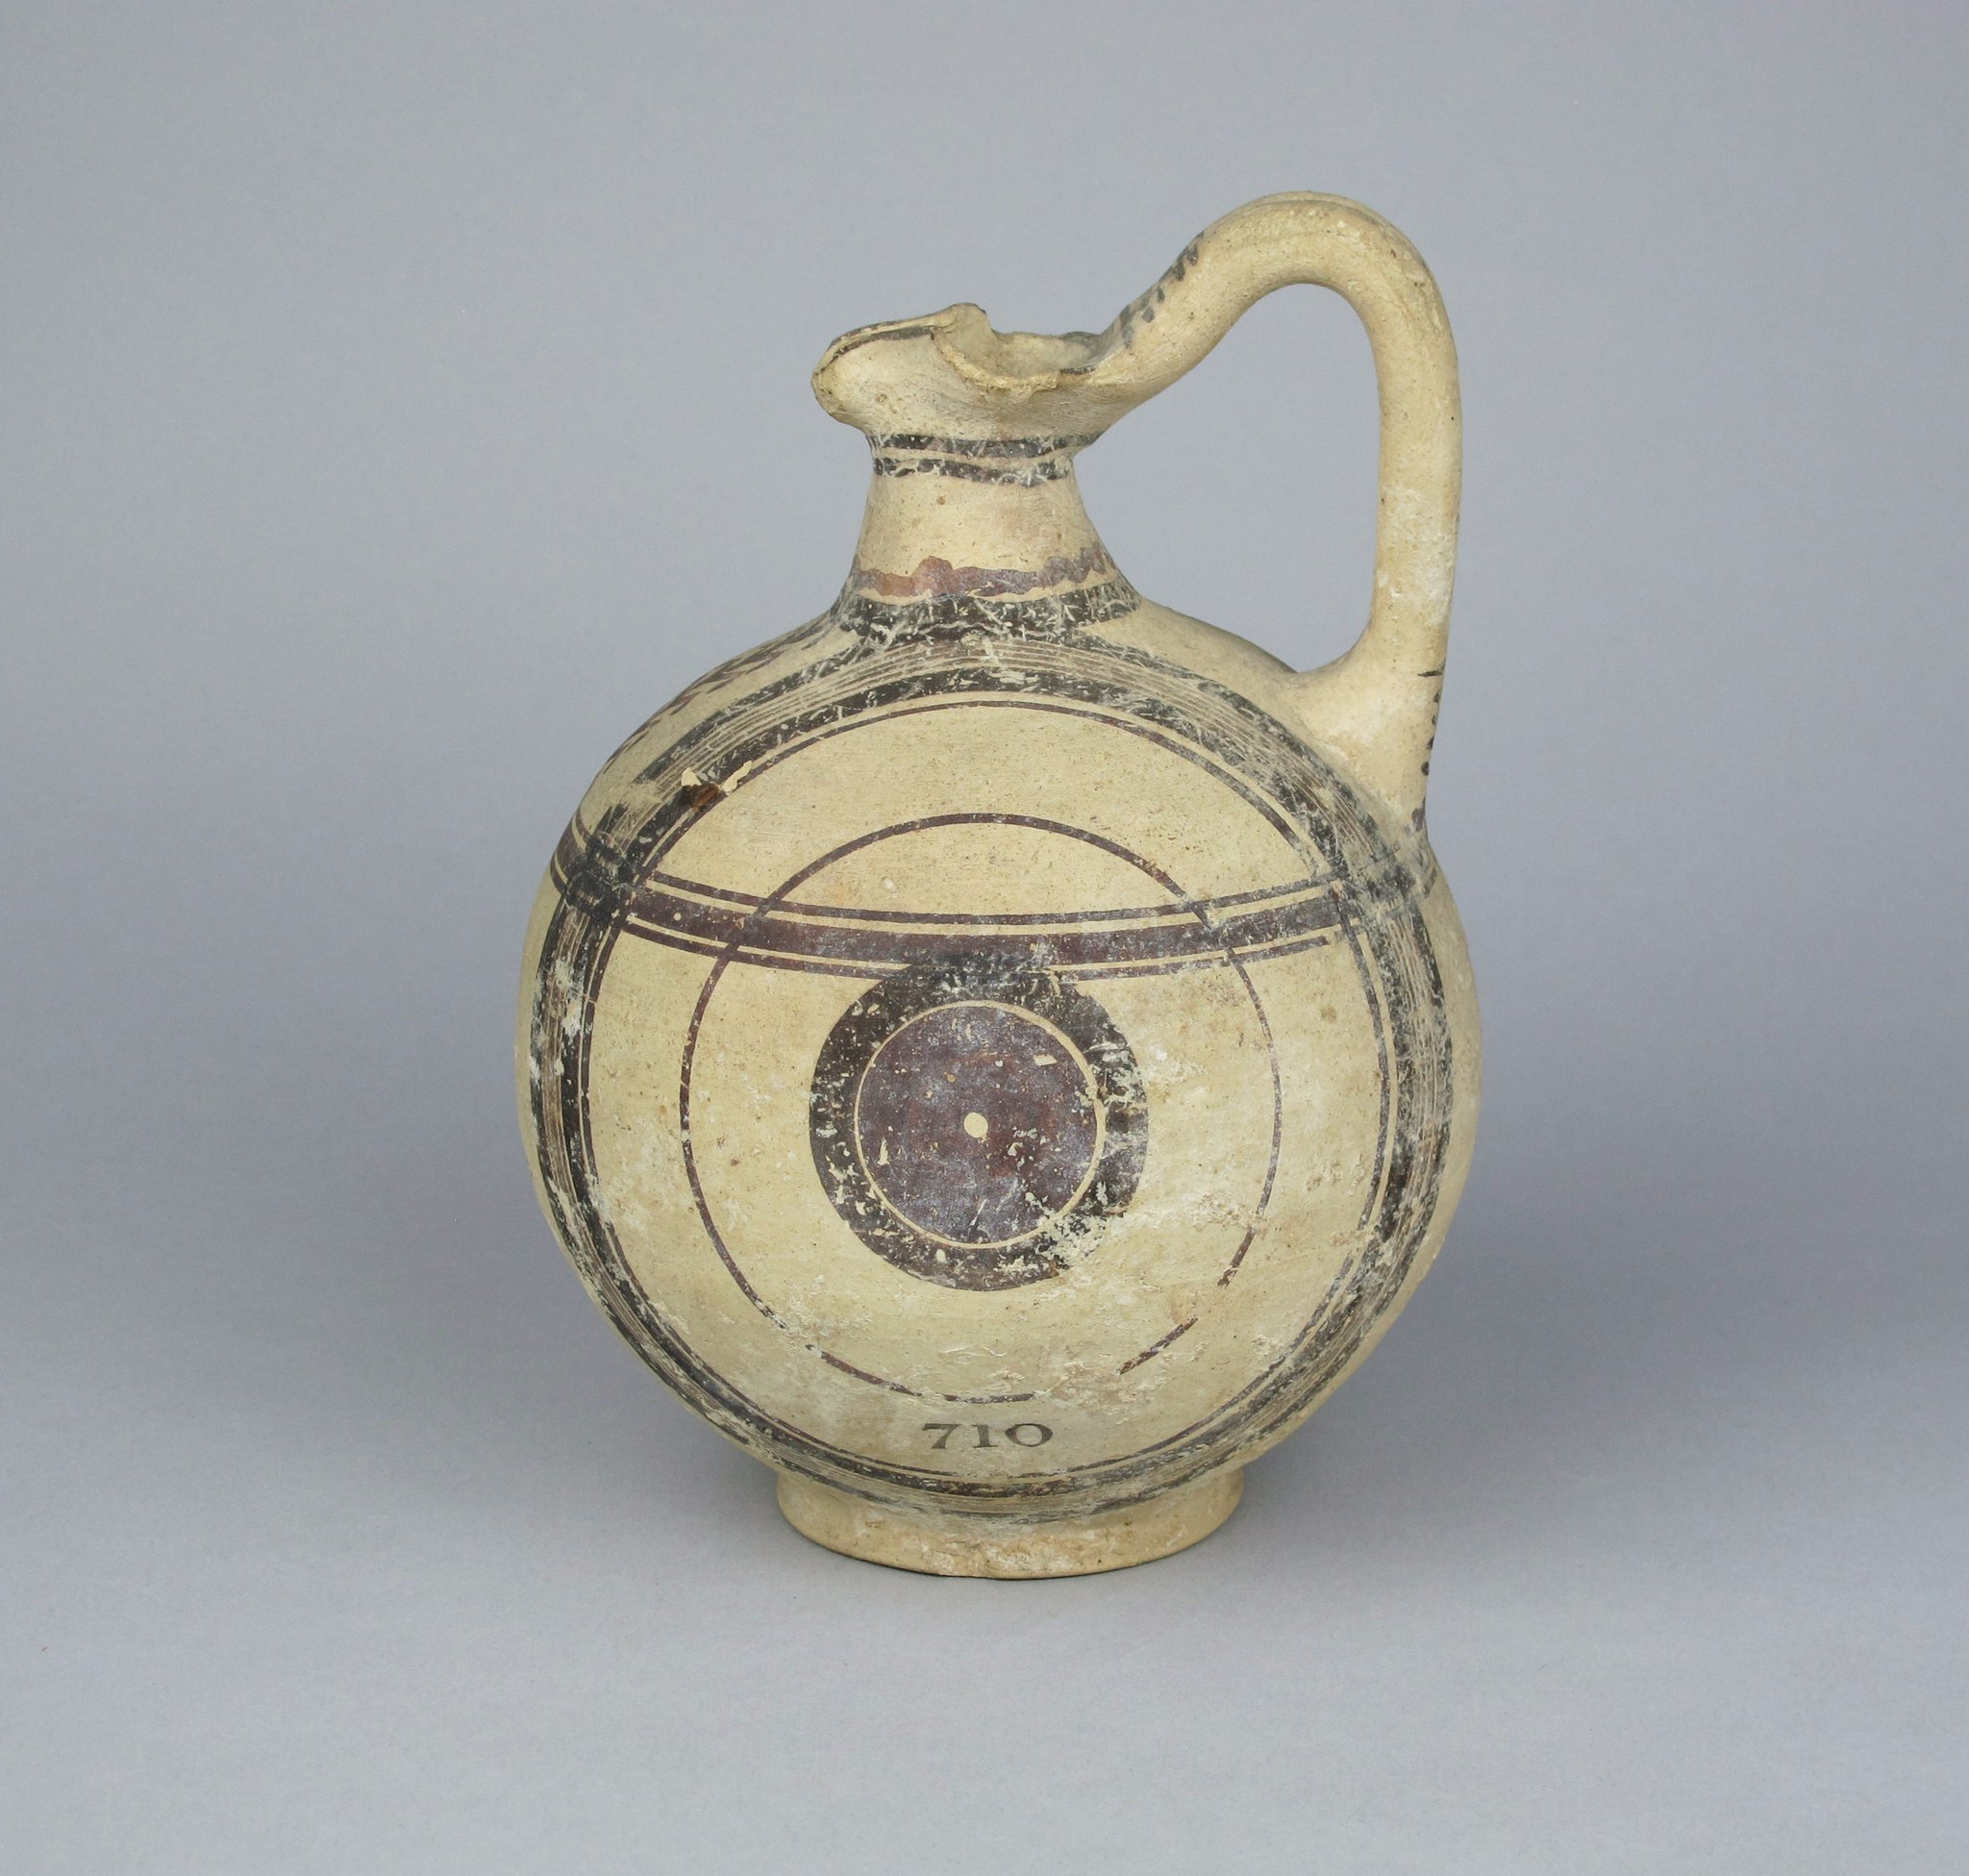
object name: jug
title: Terracotta jug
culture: cypriot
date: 600-480 BCE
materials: terracotta